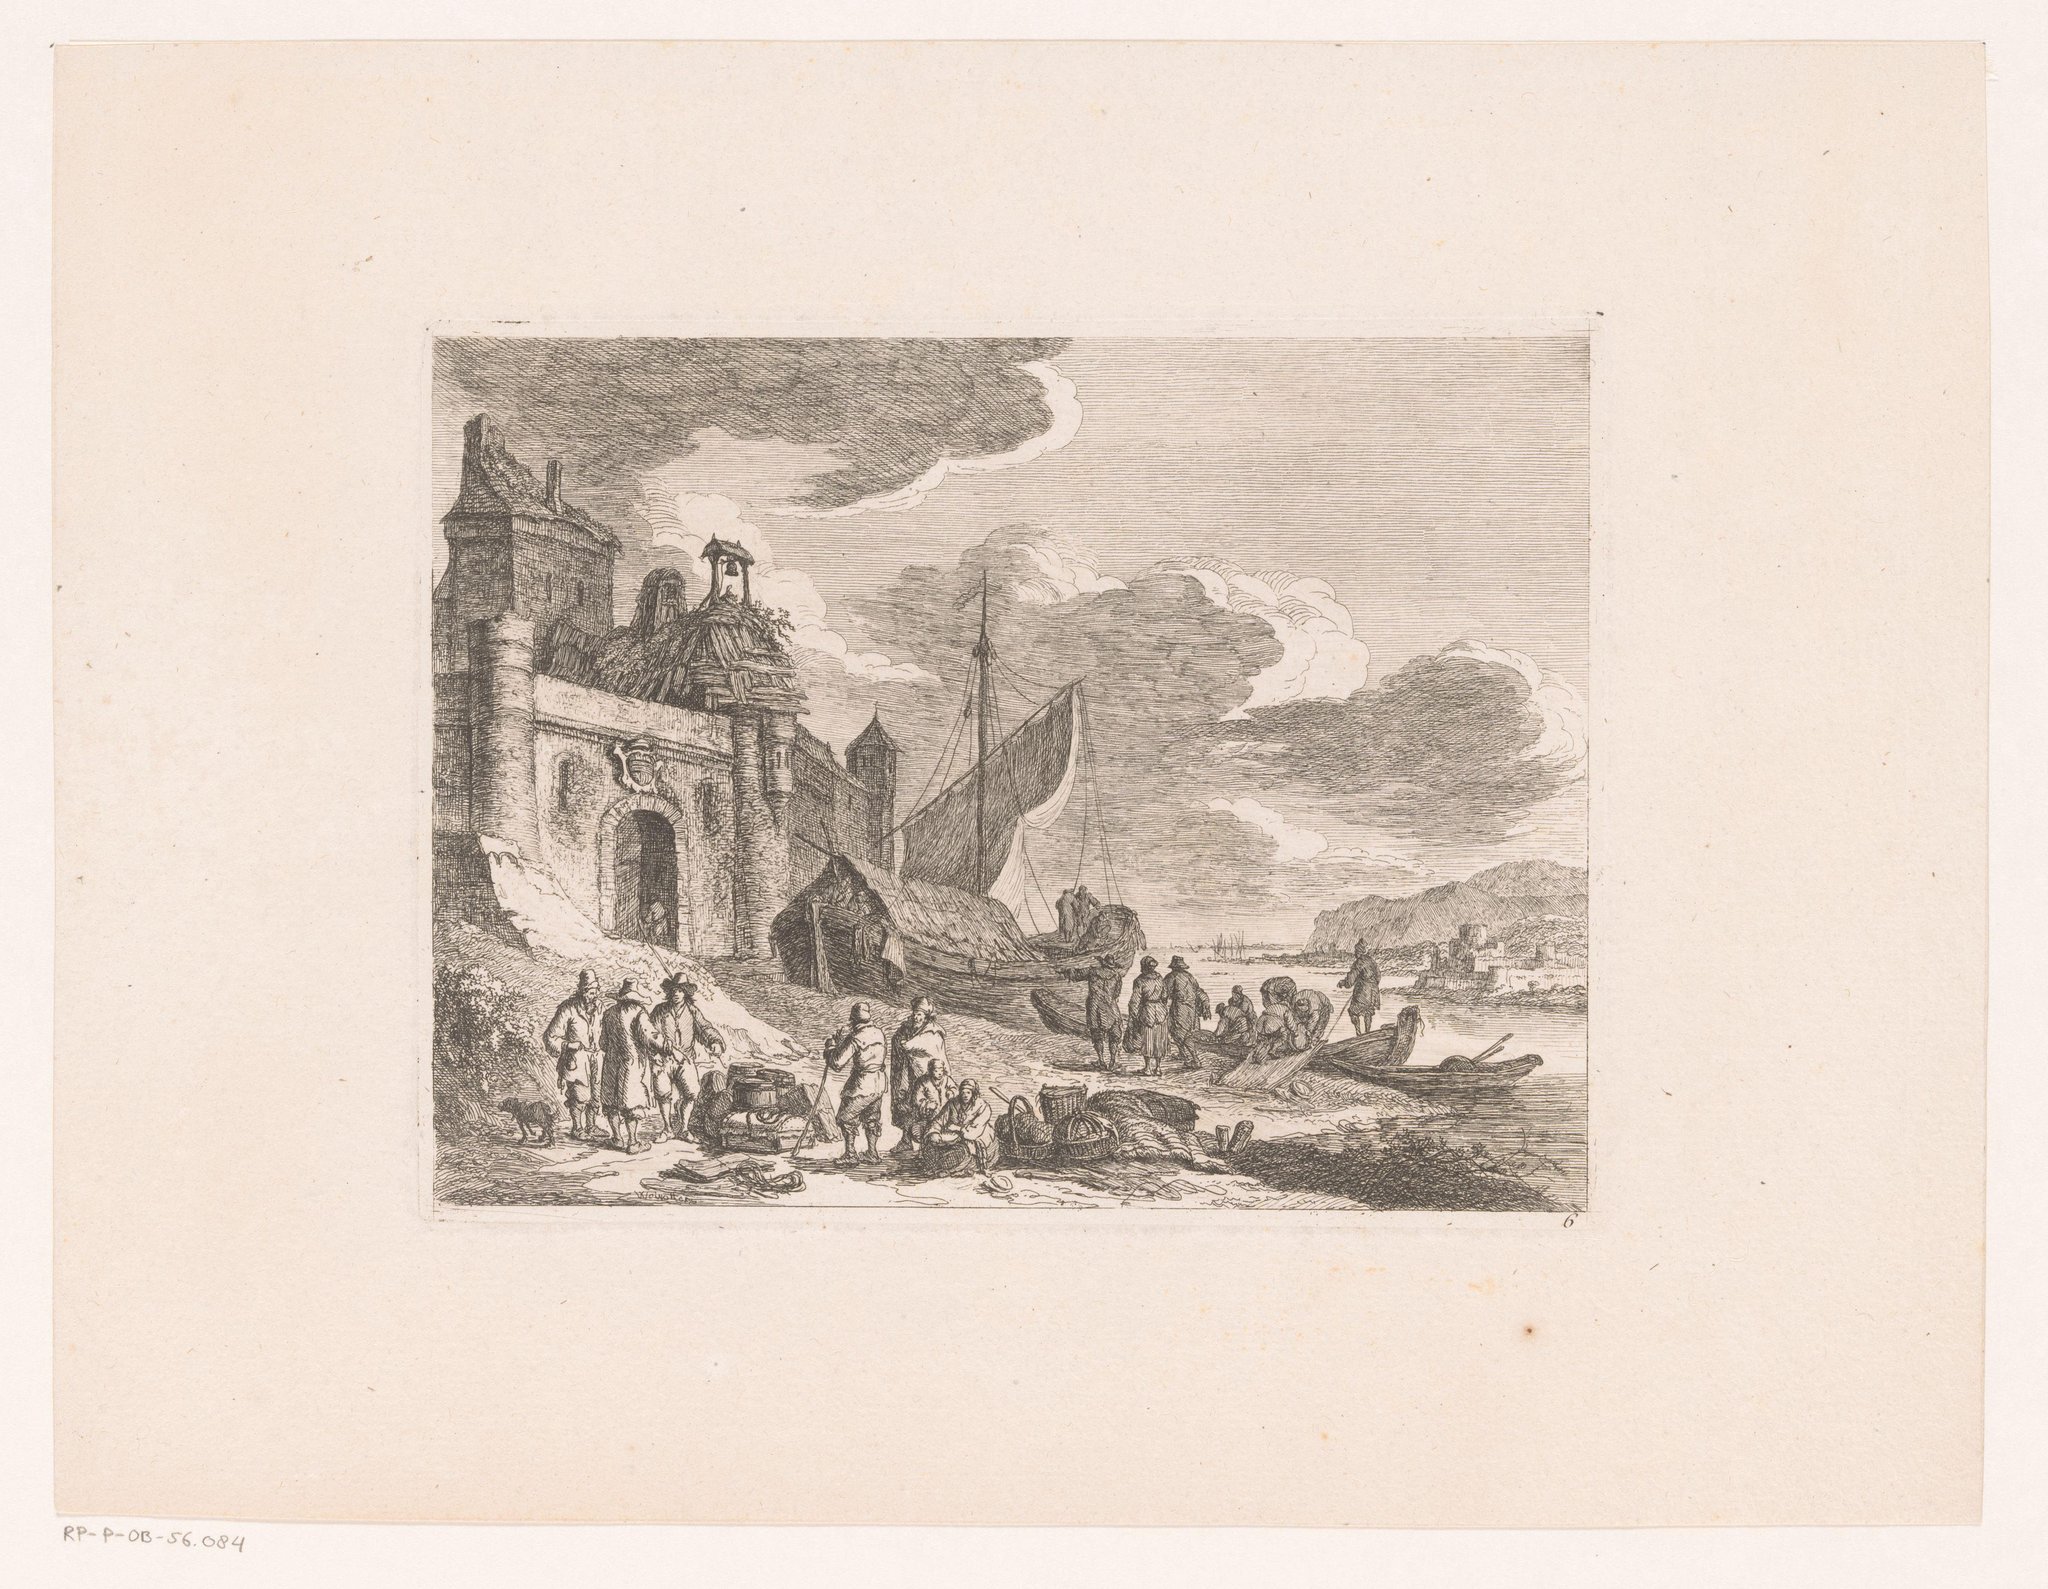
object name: print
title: Vues de la Seine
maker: franz edmund weirotter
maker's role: draughtsman, painter, print maker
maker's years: 1733-1771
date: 1761-1762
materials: paper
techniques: etching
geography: paris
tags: sailing-ship, sailing-boat, city-gate, fisherman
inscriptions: collector's mark: Lugt 240